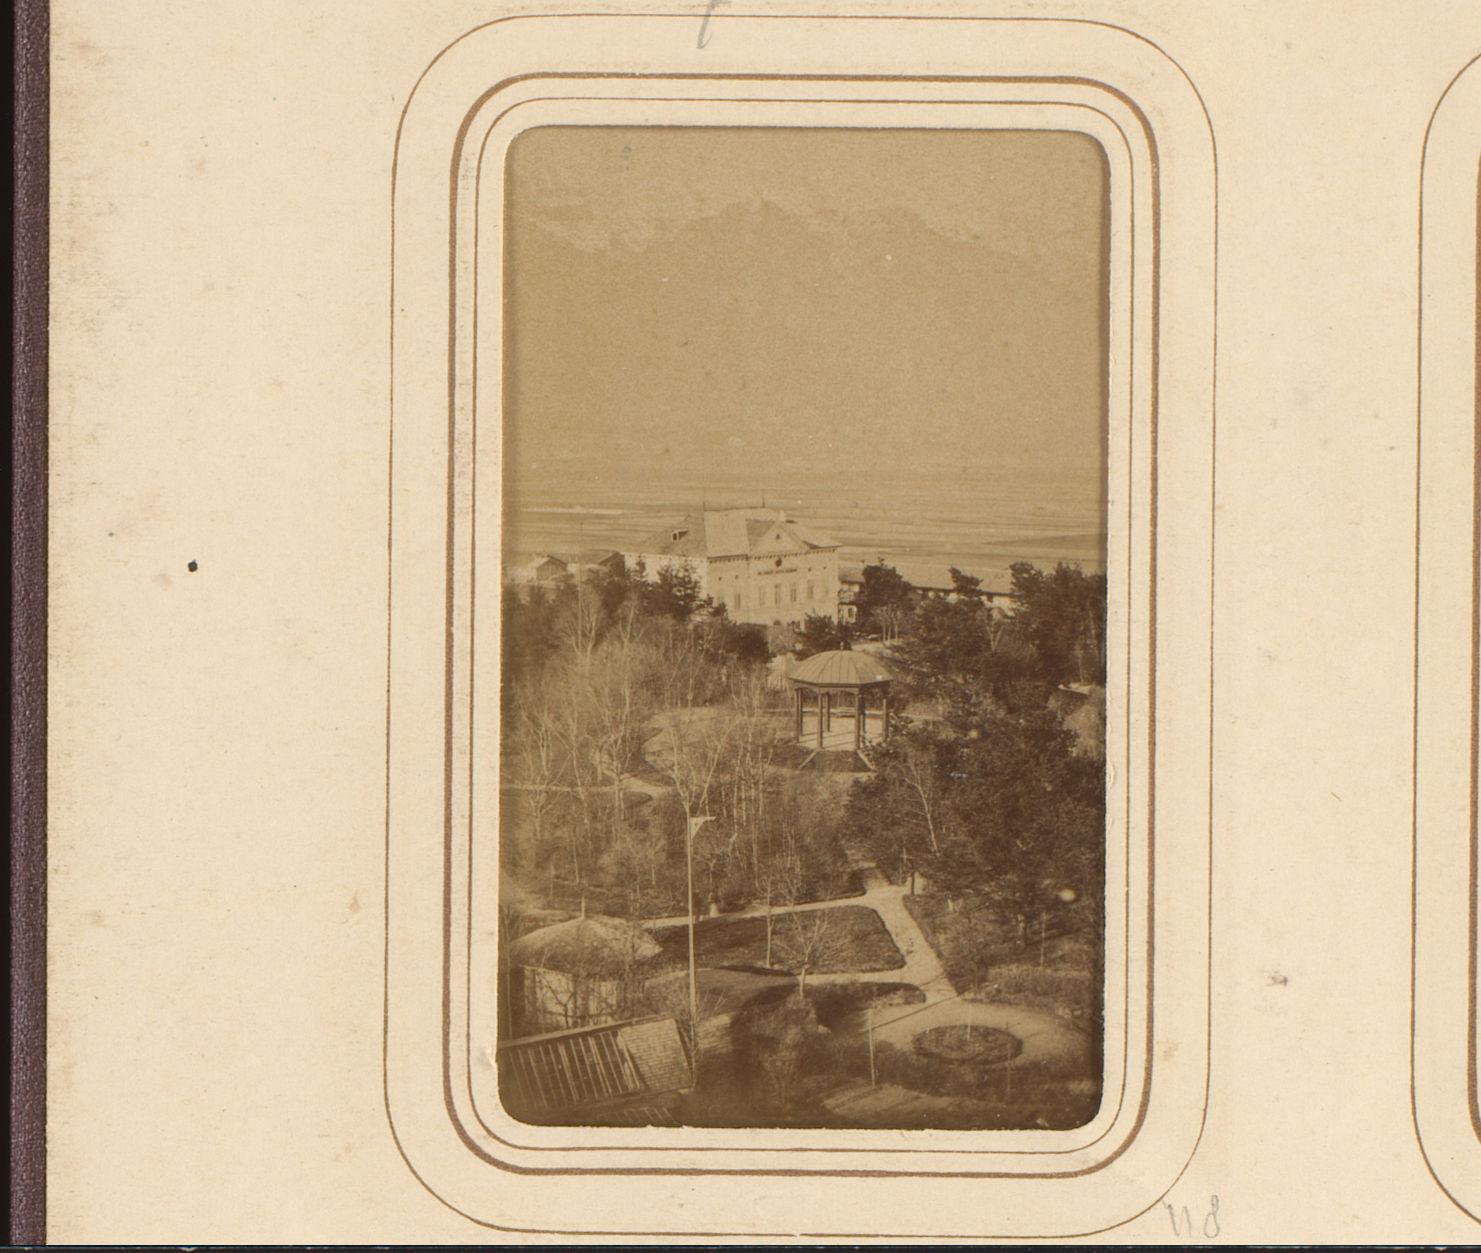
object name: album leaf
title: Kiosk en gebouw in en aan een park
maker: Anonymous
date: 1865-1890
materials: cardboard, photographic support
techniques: albumen print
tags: trees, civic architecture; edifices; dwellings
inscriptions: annotation: ‘Bery Isel’